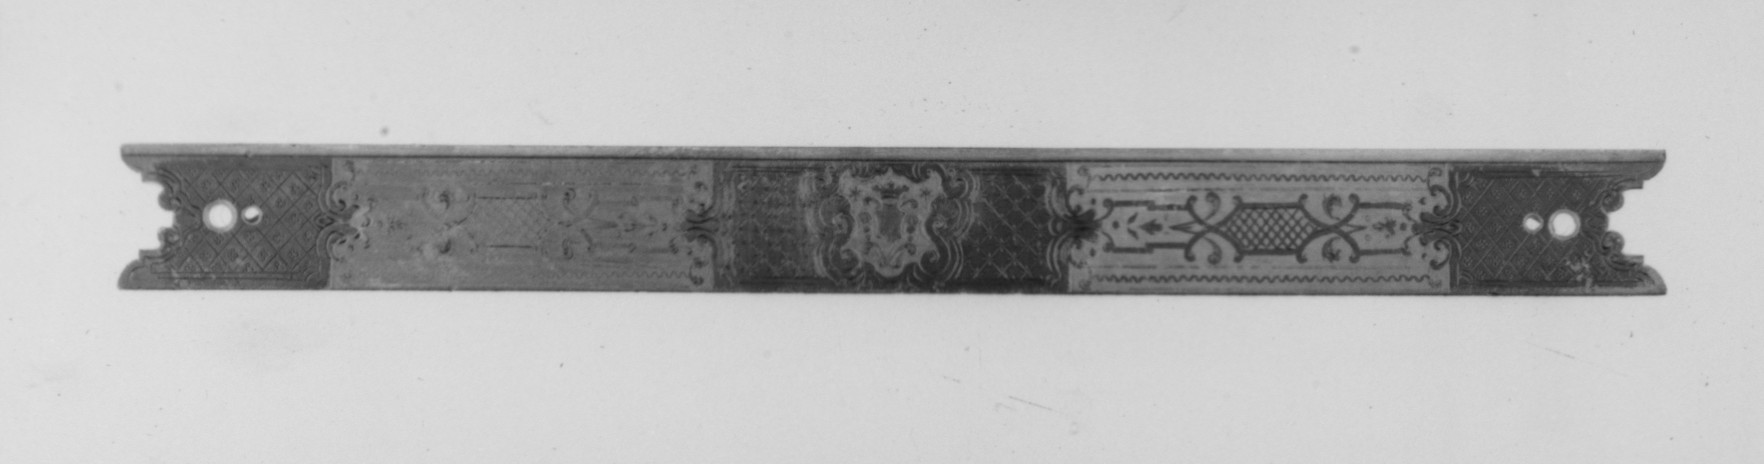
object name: straight edge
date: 1701-1800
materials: iron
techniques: gilding, silvered